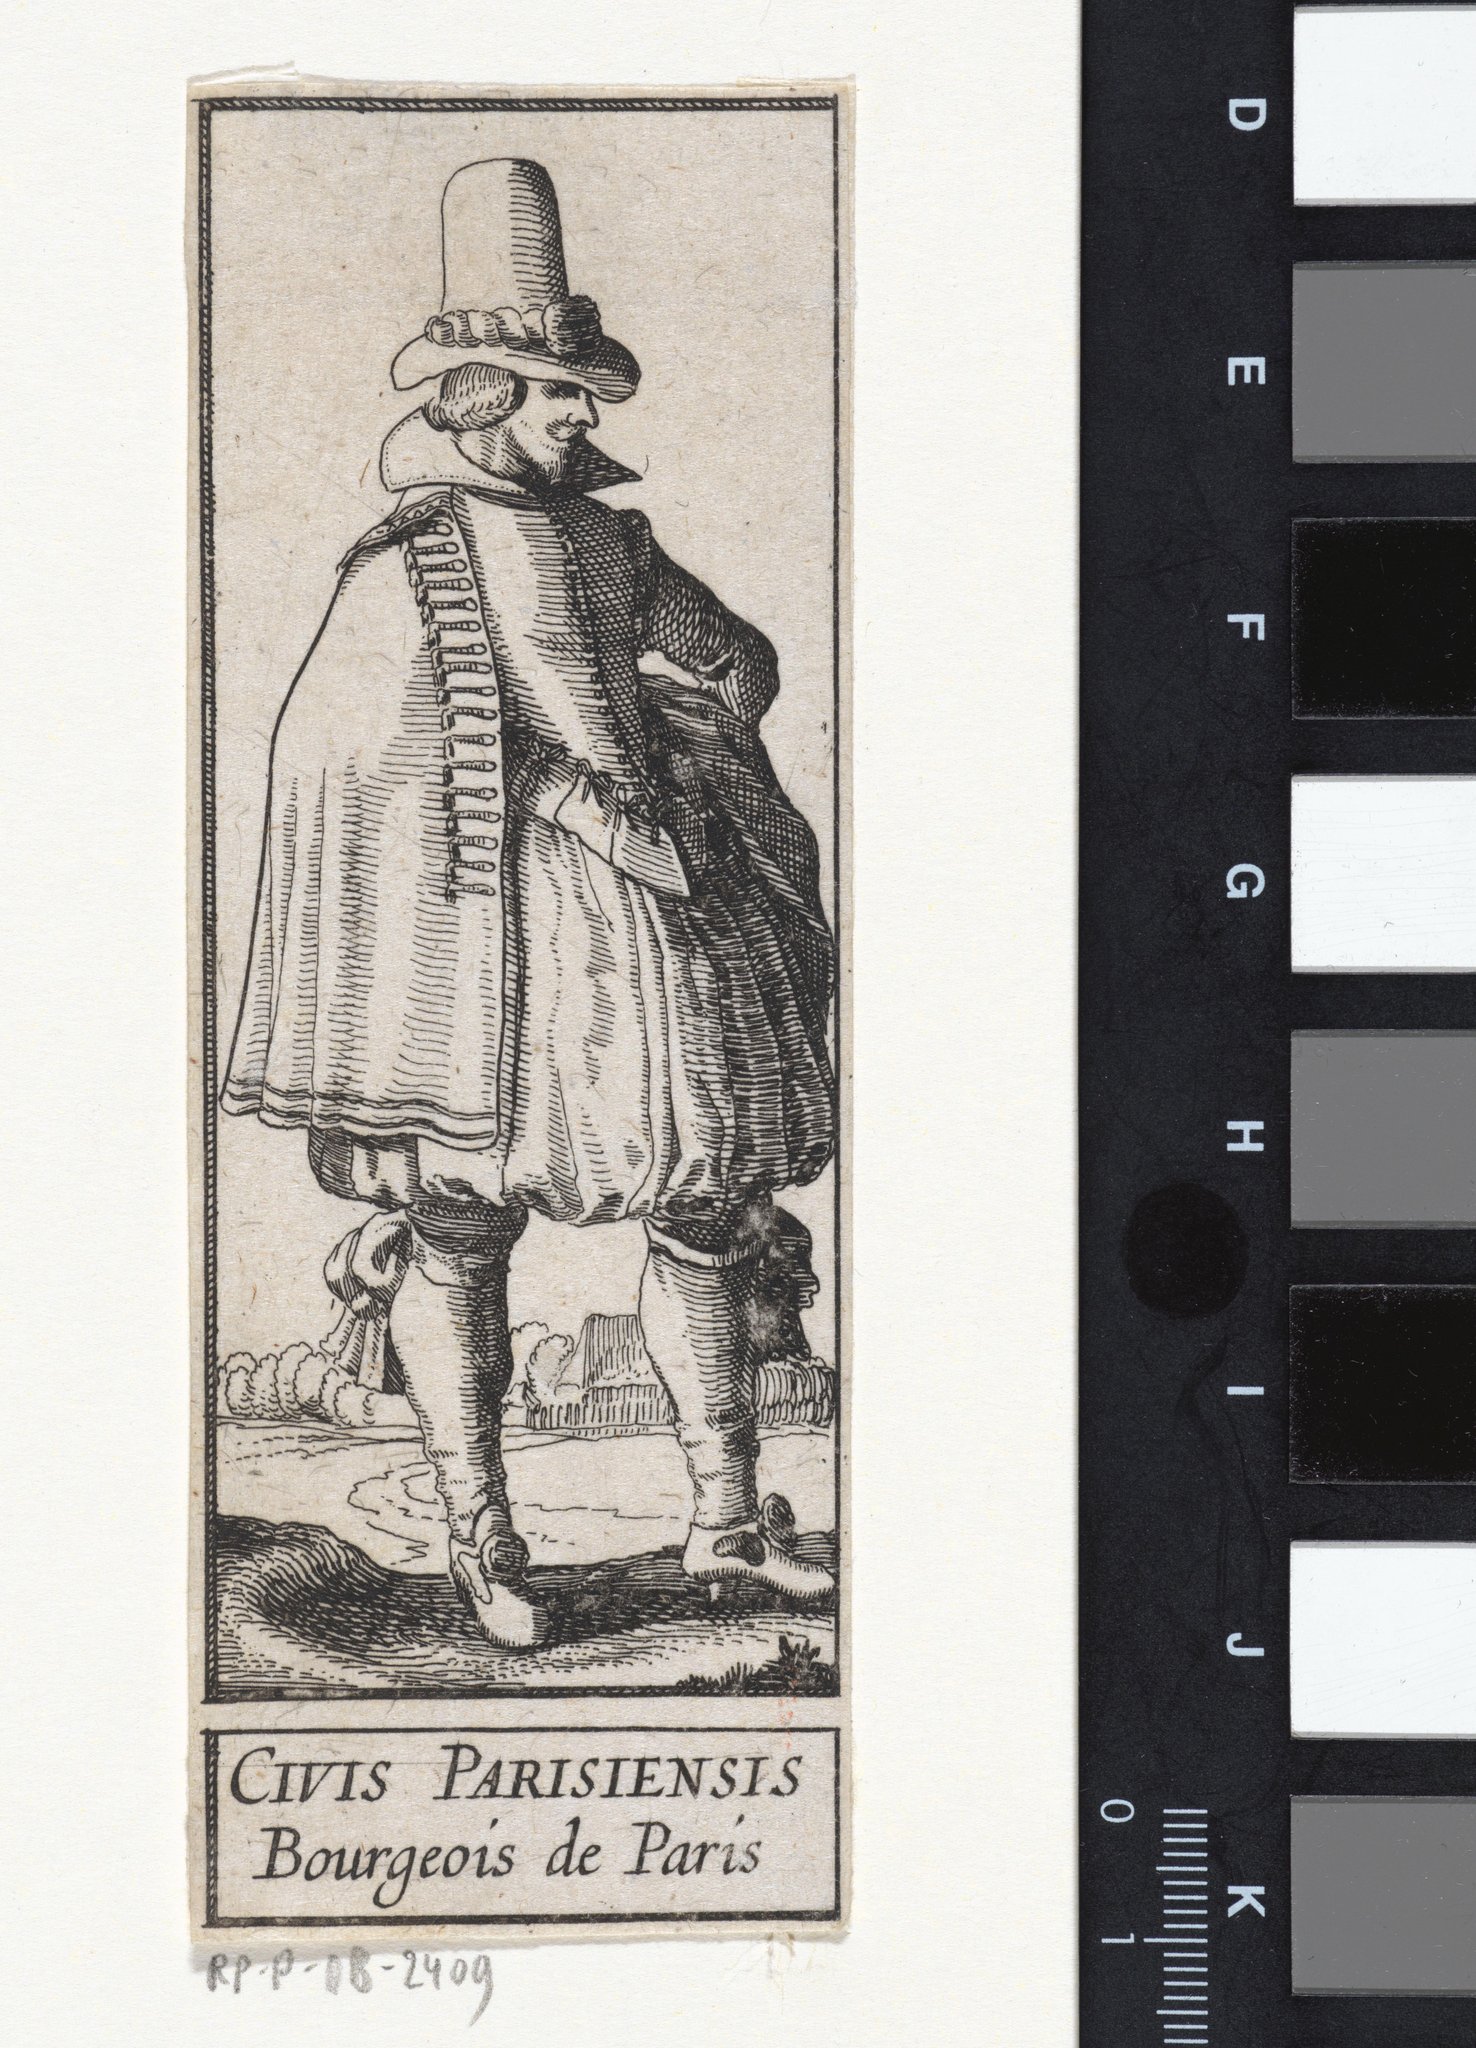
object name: costume print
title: CIVIS PARISIENSIS: Bourgeois de Paris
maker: claes jansz. visscher (ii)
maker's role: draughtsman, print maker, publisher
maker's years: 1586-1652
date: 1618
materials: paper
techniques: etching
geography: amsterdam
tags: europeans (with name), bourgeoisie, middle class, citizens, burghers, clothes, costume (+ men's clothes)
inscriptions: collector's mark: Lugt 240, caption: ‘CIVIS PARISIENSIS: Bourgeois de Paris’, collector's mark: Lugt 1838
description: burgerlijke kleding: hoed met cilindervormige bol; mantel met passement. Zeer wijde boven de knie vallende dichtgebonden broek. Kousebanden met strik. Wambuis met puntlijf en schootpanden met strikjes. Schoenen hak en hoge wreef.